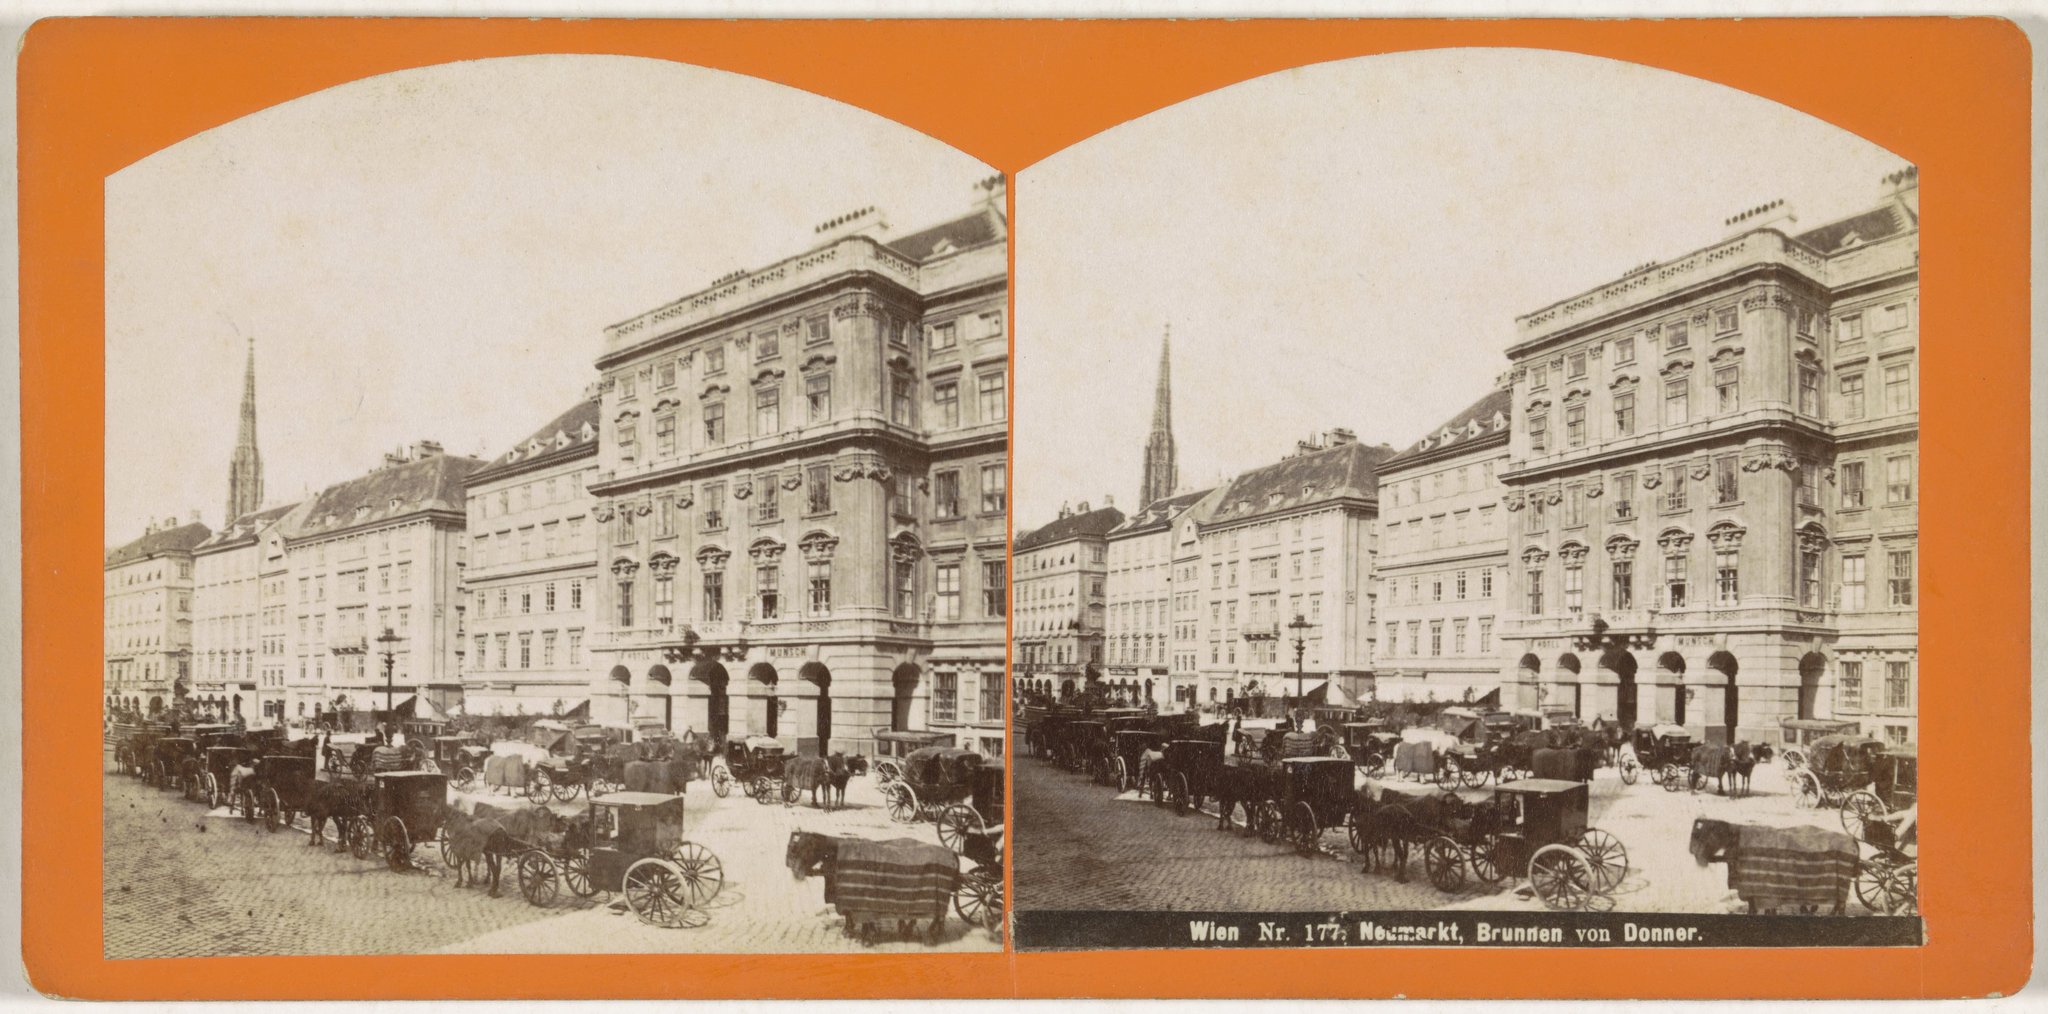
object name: stereograph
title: Rijtuigen bij de Donnerfontein op de Neuer Markt, Wenen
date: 1876-1898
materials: cardboard, paper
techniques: albumen print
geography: vienna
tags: square, place, circus, etc.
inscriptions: inscription: ‘Editeur de Photographie (...) en Detail.’, number: ‘Nr. 177’